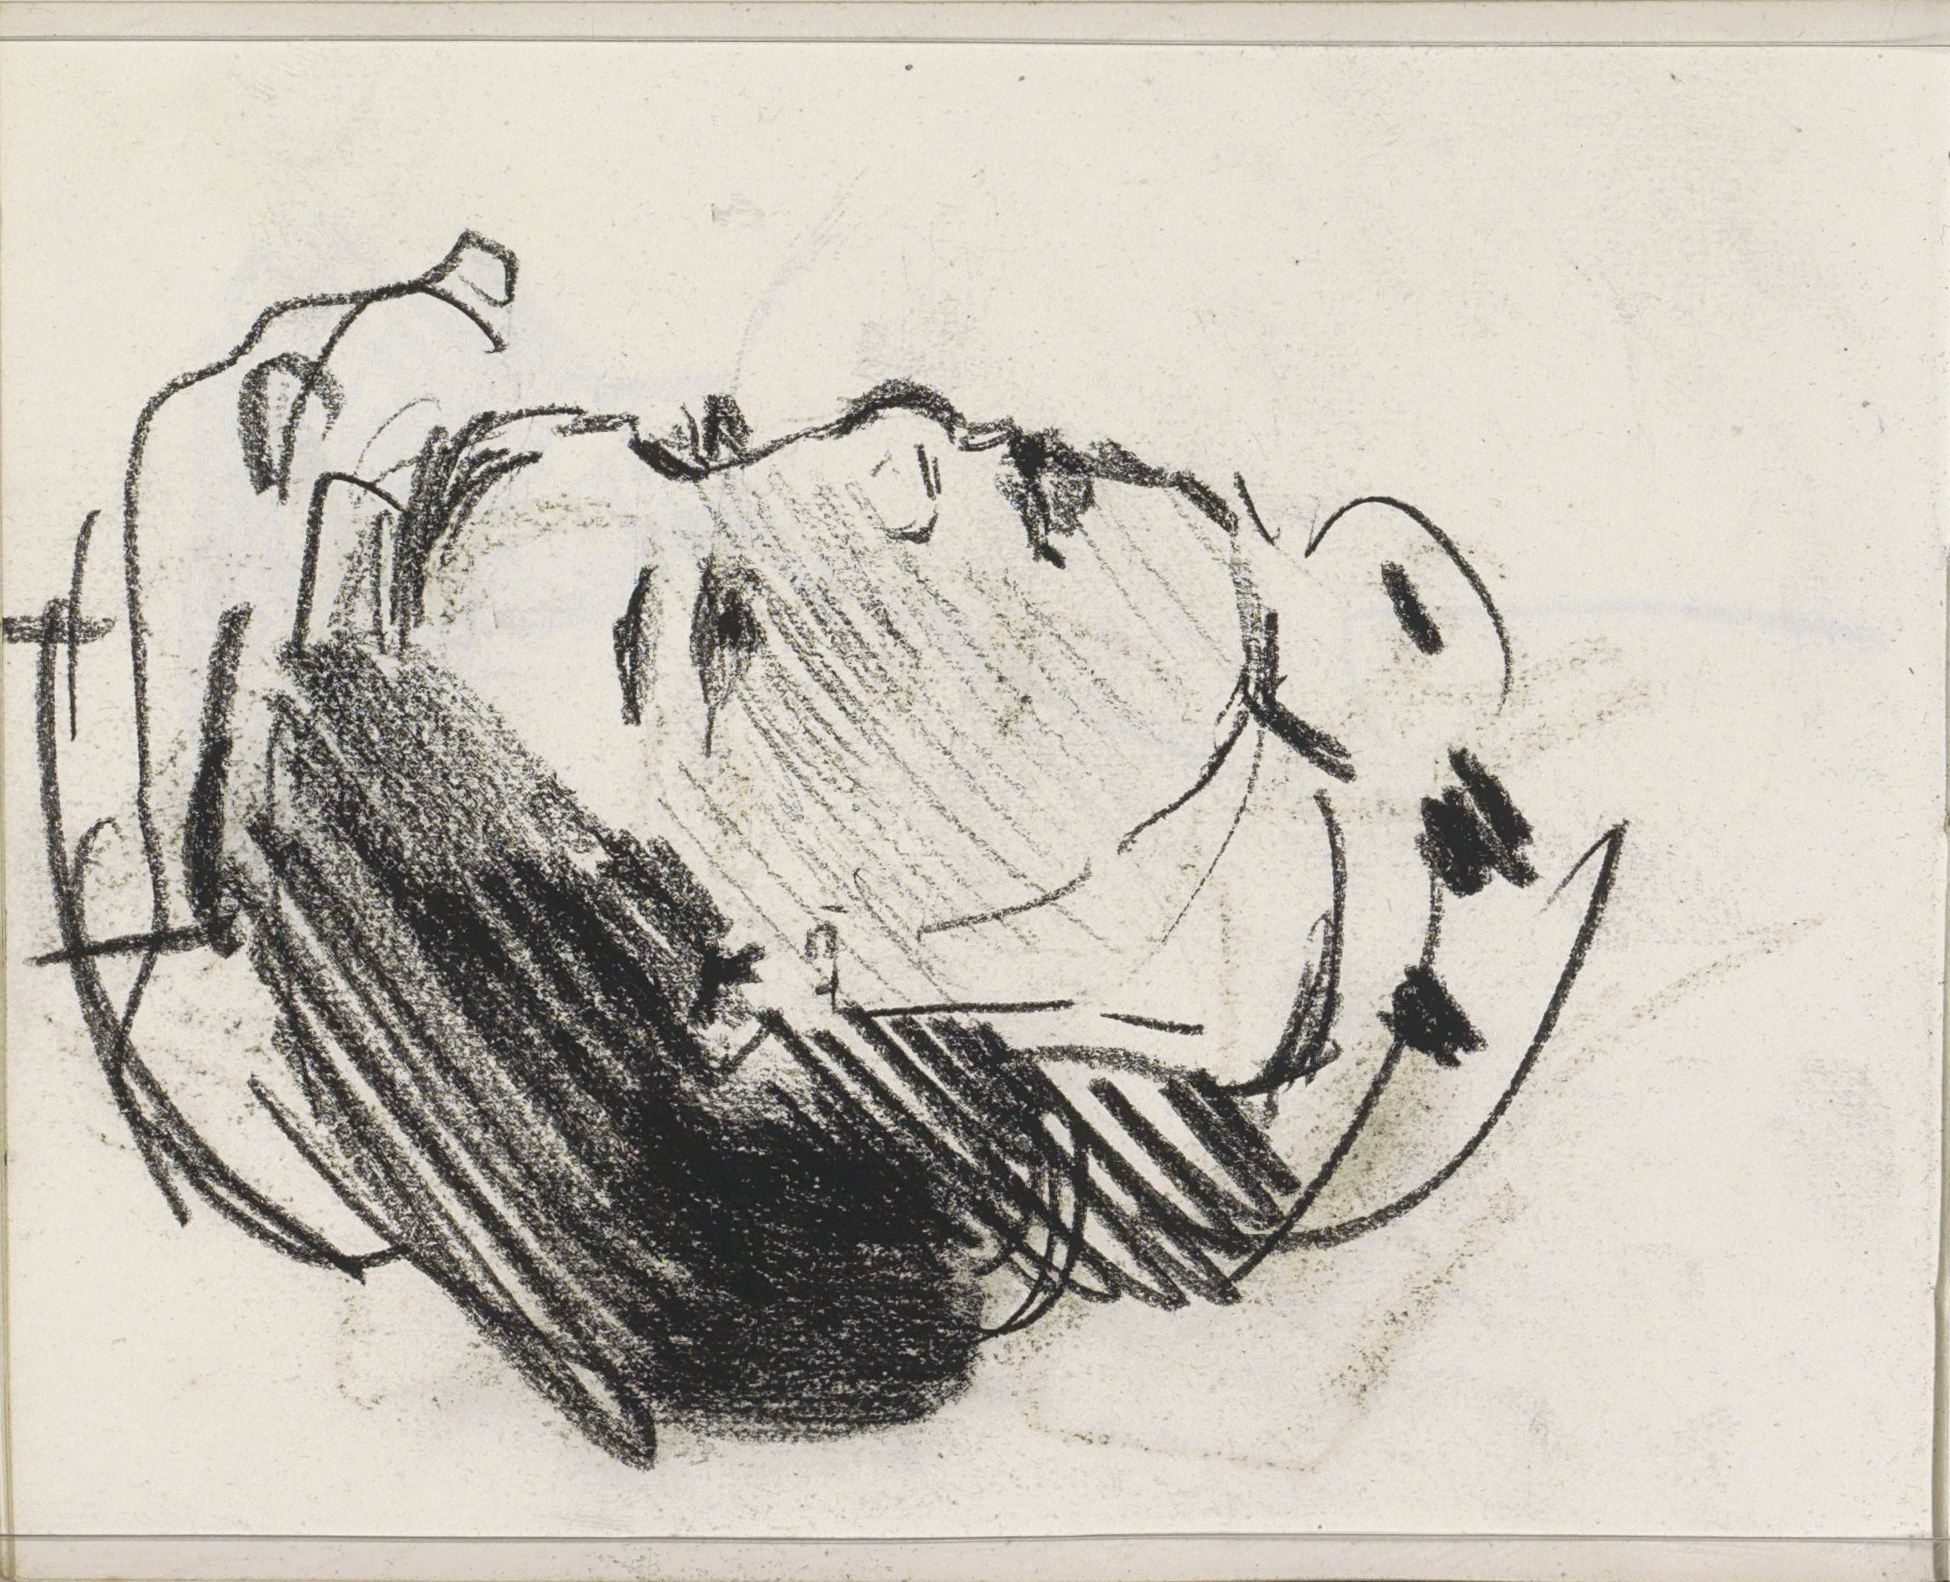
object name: sketchbook leaf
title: Vrouwenhoofd met hoed, in profiel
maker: isaac israels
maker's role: draughtsman, painter, print maker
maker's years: 1865-1934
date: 1875-1934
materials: chalk, paper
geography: the hague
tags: head-gear: hat (+ women's clothes), head (human) - aa - female human figure (+ sideview, profile)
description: Pagina 47 uit schetsboek XLIII met 61 pagina's.